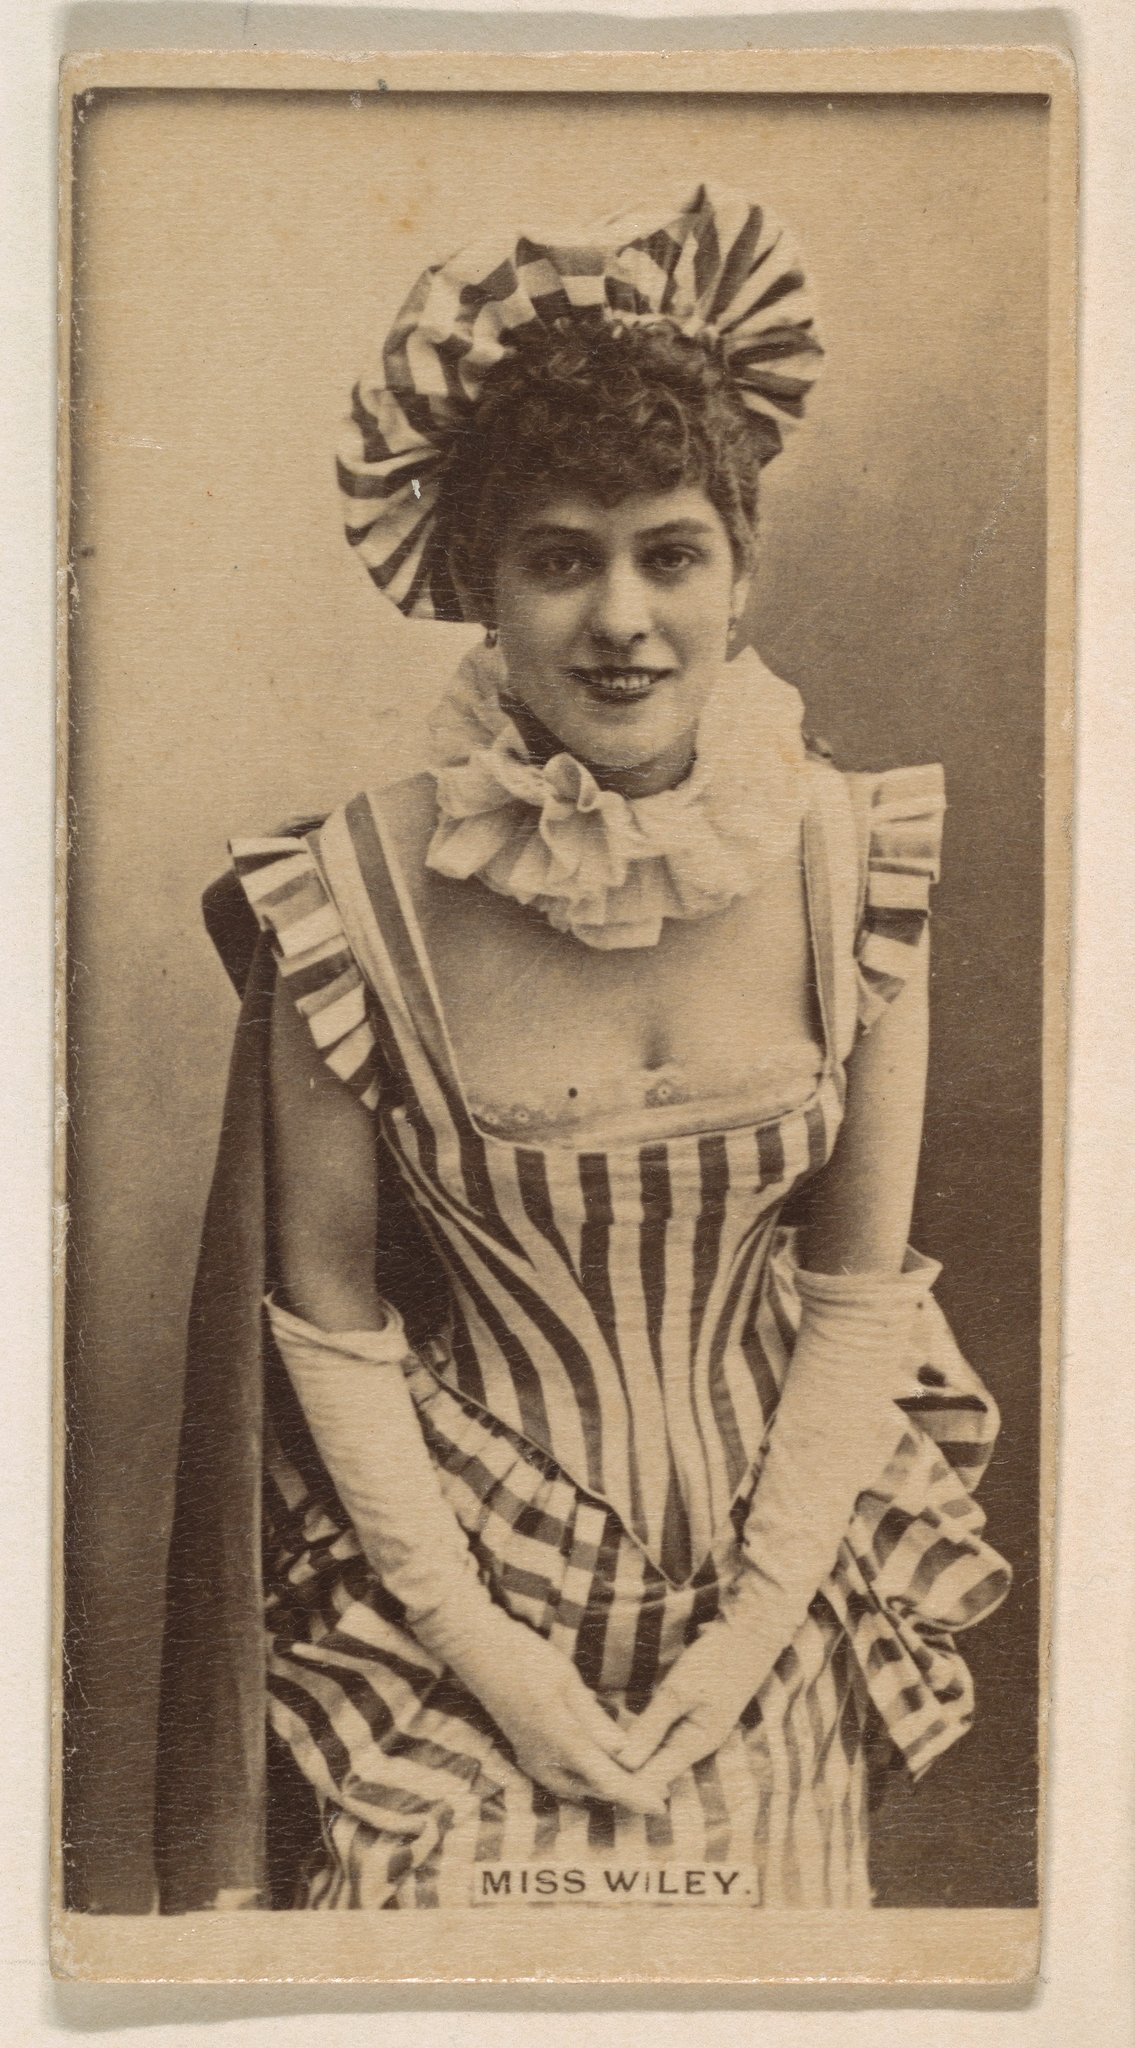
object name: photograph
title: Miss Wiley, from the Actresses series (N245) issued by Kinney Brothers to promote Sweet Caporal Cigarettes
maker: kinney brothers tobacco company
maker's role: publisher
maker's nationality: american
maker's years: 1869-2011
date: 1890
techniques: albumen silver print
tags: portraits,women,actresses